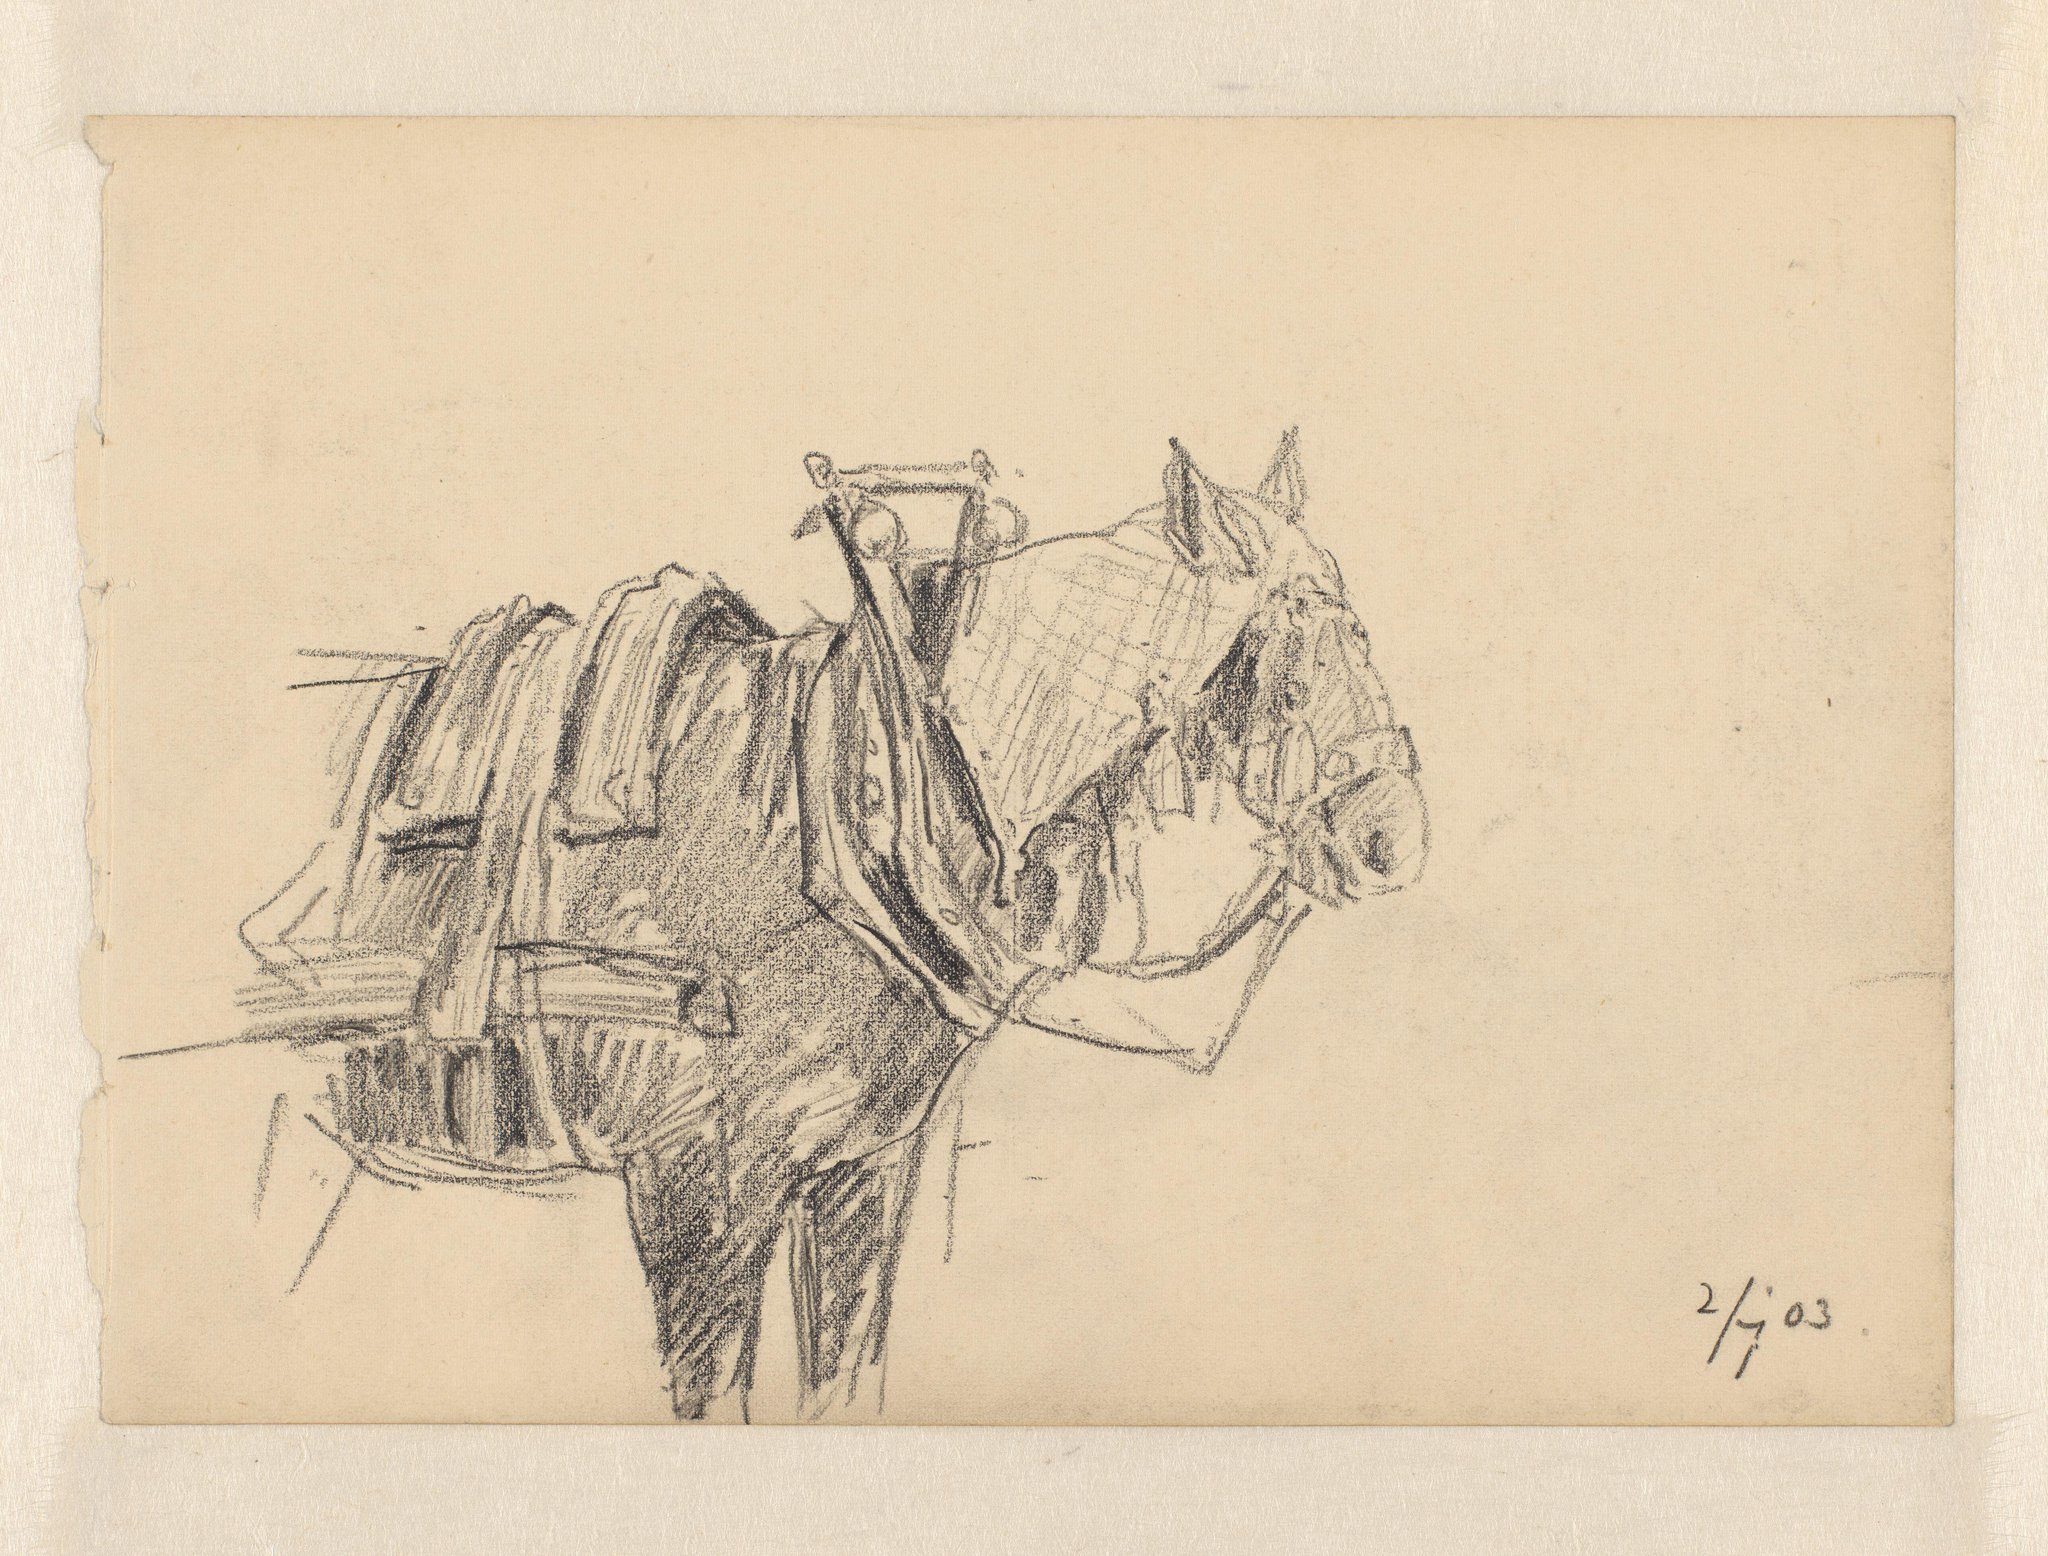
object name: drawing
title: Aangespannen karrepaard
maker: pieter h.j.j. ras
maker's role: draughtsman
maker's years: 1857-1941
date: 1903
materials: chalk, paper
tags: horse